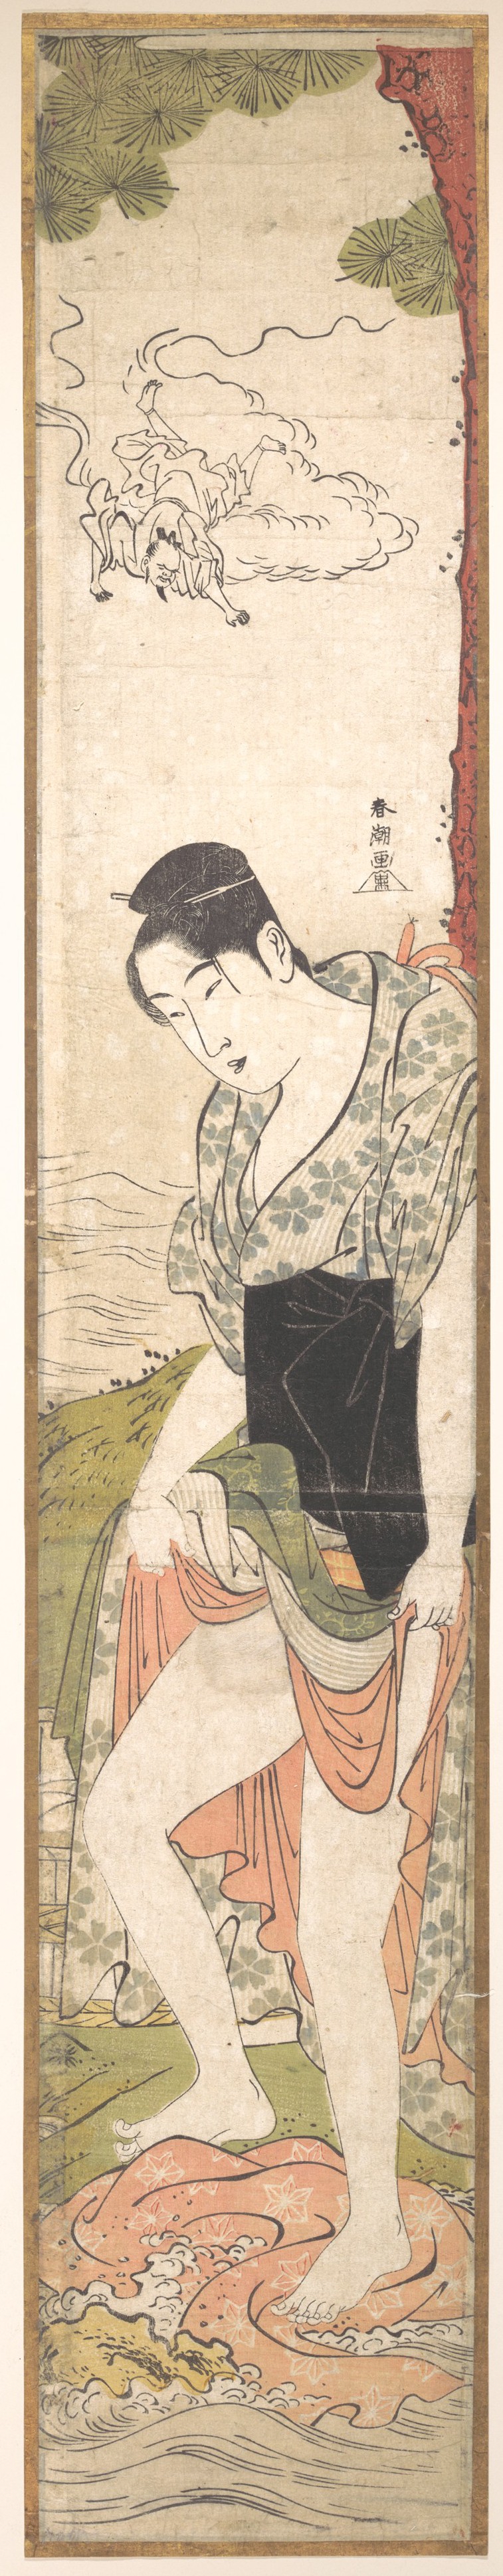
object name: woodblock print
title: Young Woman Washing Clothes in the River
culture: japanese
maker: katsukawa shunchō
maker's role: artist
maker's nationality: japanese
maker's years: 1775-1795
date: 1780-1795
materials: ink, paper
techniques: woodblock print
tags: women,washing